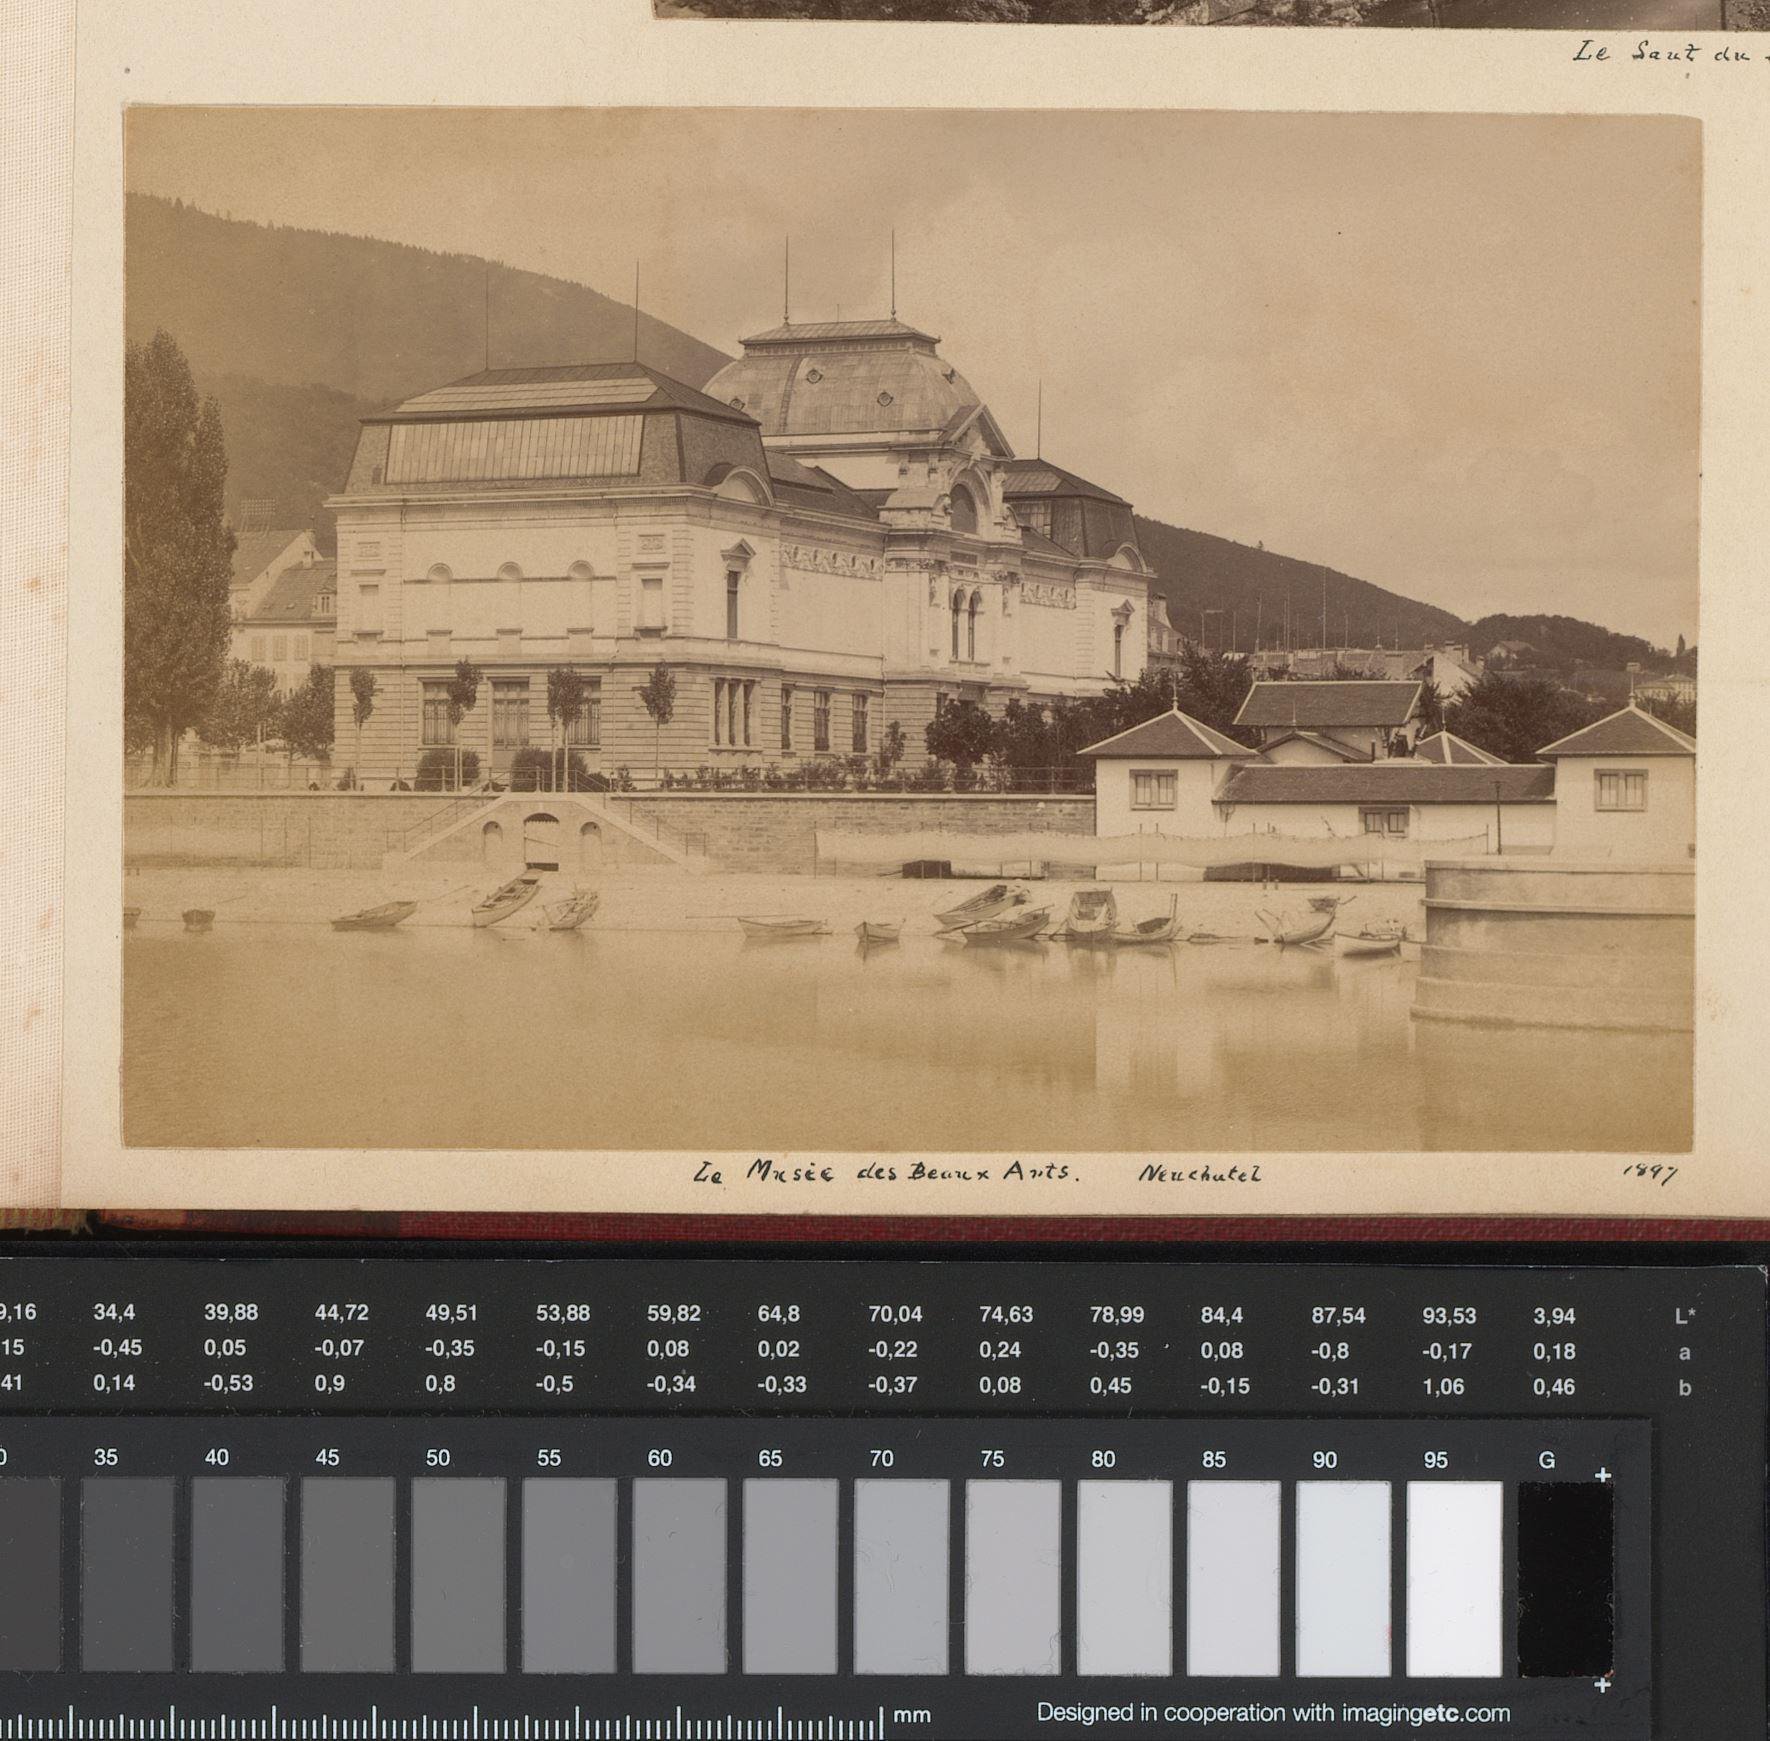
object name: album leaf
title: Gezicht op het conservatorium te Neuchâtel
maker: Anonymous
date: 1897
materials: cardboard, photographic support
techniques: albumen print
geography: neuchatel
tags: academy, association of artists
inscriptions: annotation: ‘Le Music des Beaux Arts. Neuchatel 1897’